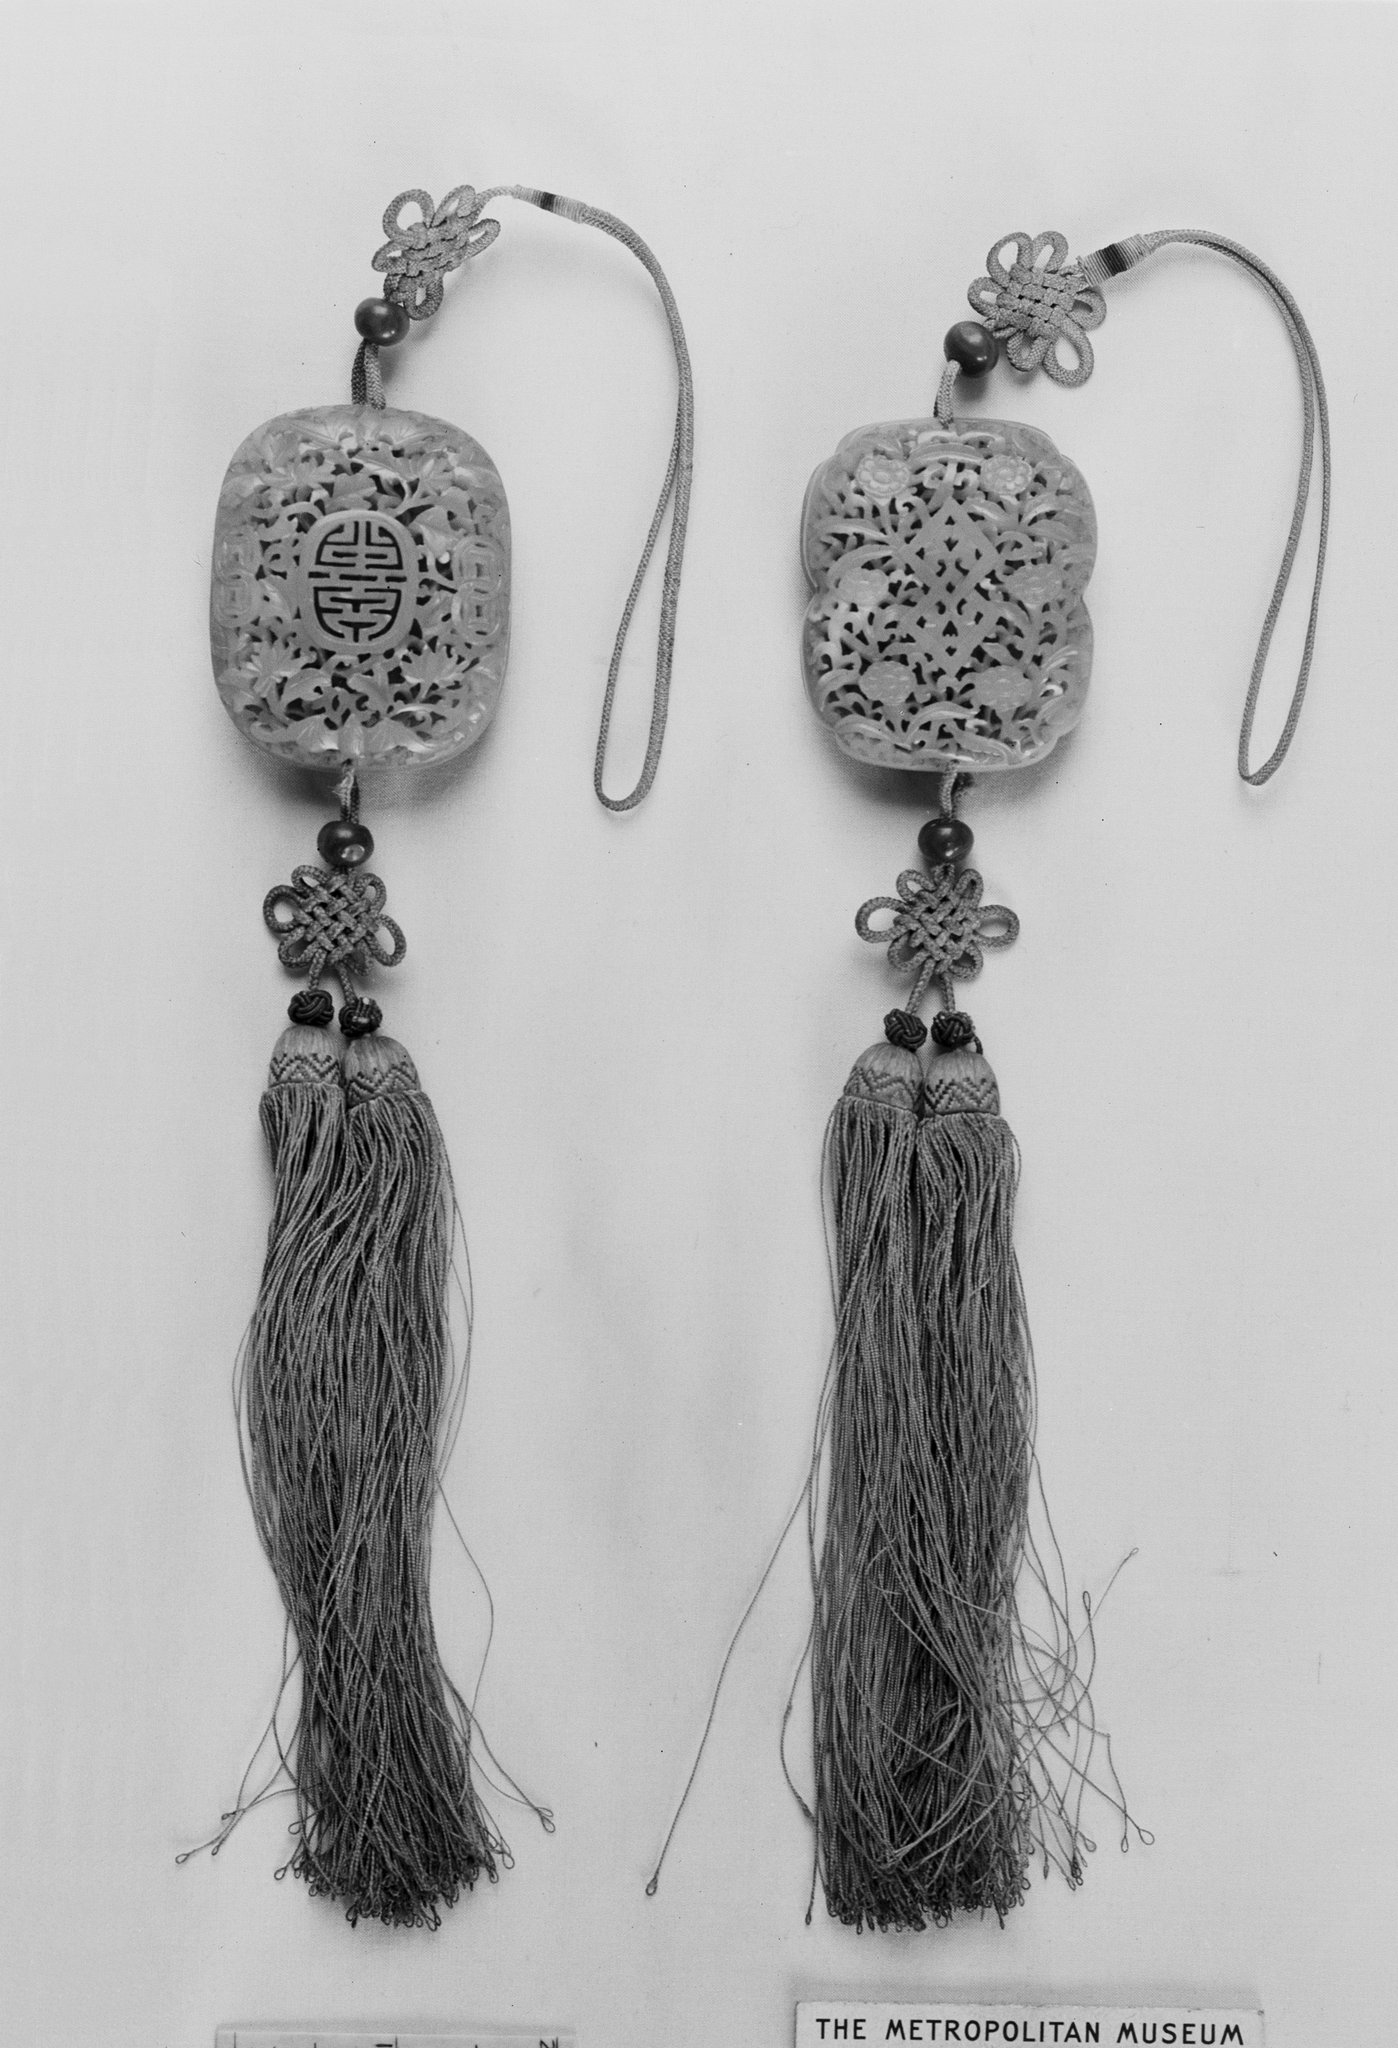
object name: perfume receptacle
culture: chinese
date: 1736-1795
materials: jade